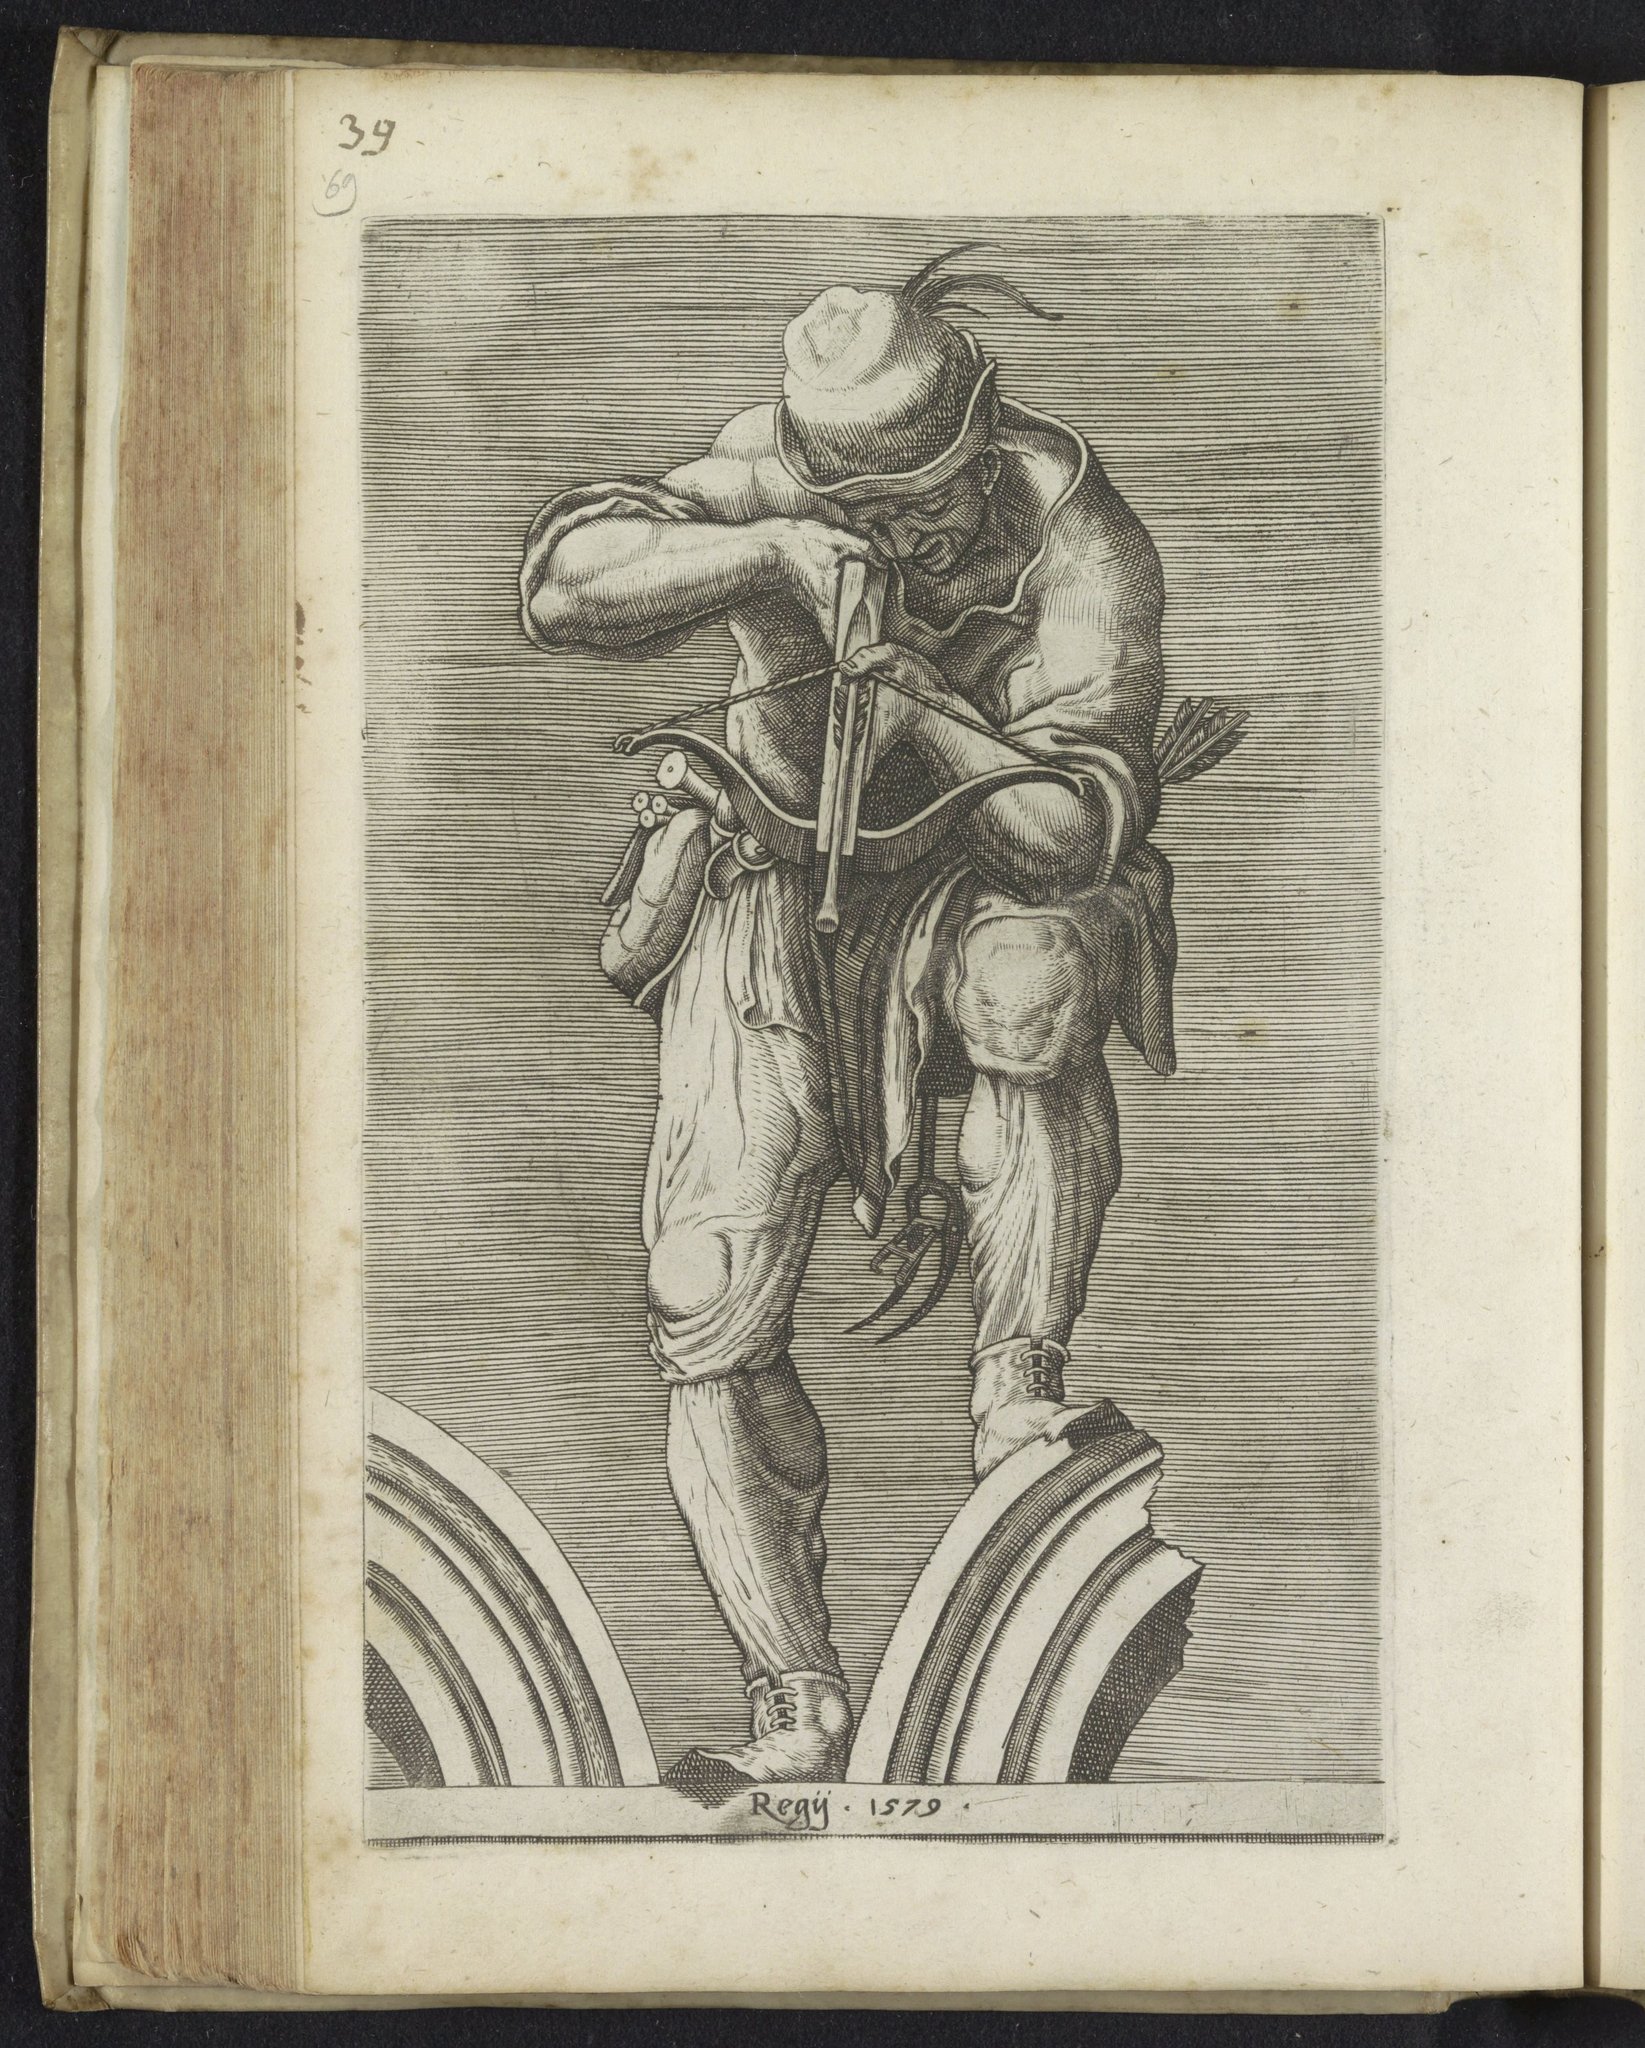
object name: album leaf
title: Jager met een kruisboog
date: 1579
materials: paper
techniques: engraving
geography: rome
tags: hunter, archer's weapons: crossbow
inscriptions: number: ‘39’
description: Deze prent maakt deel uit van een set van 79 prenten (+ titelprent) met voorstellingen van antieke sculpturen in Rome.